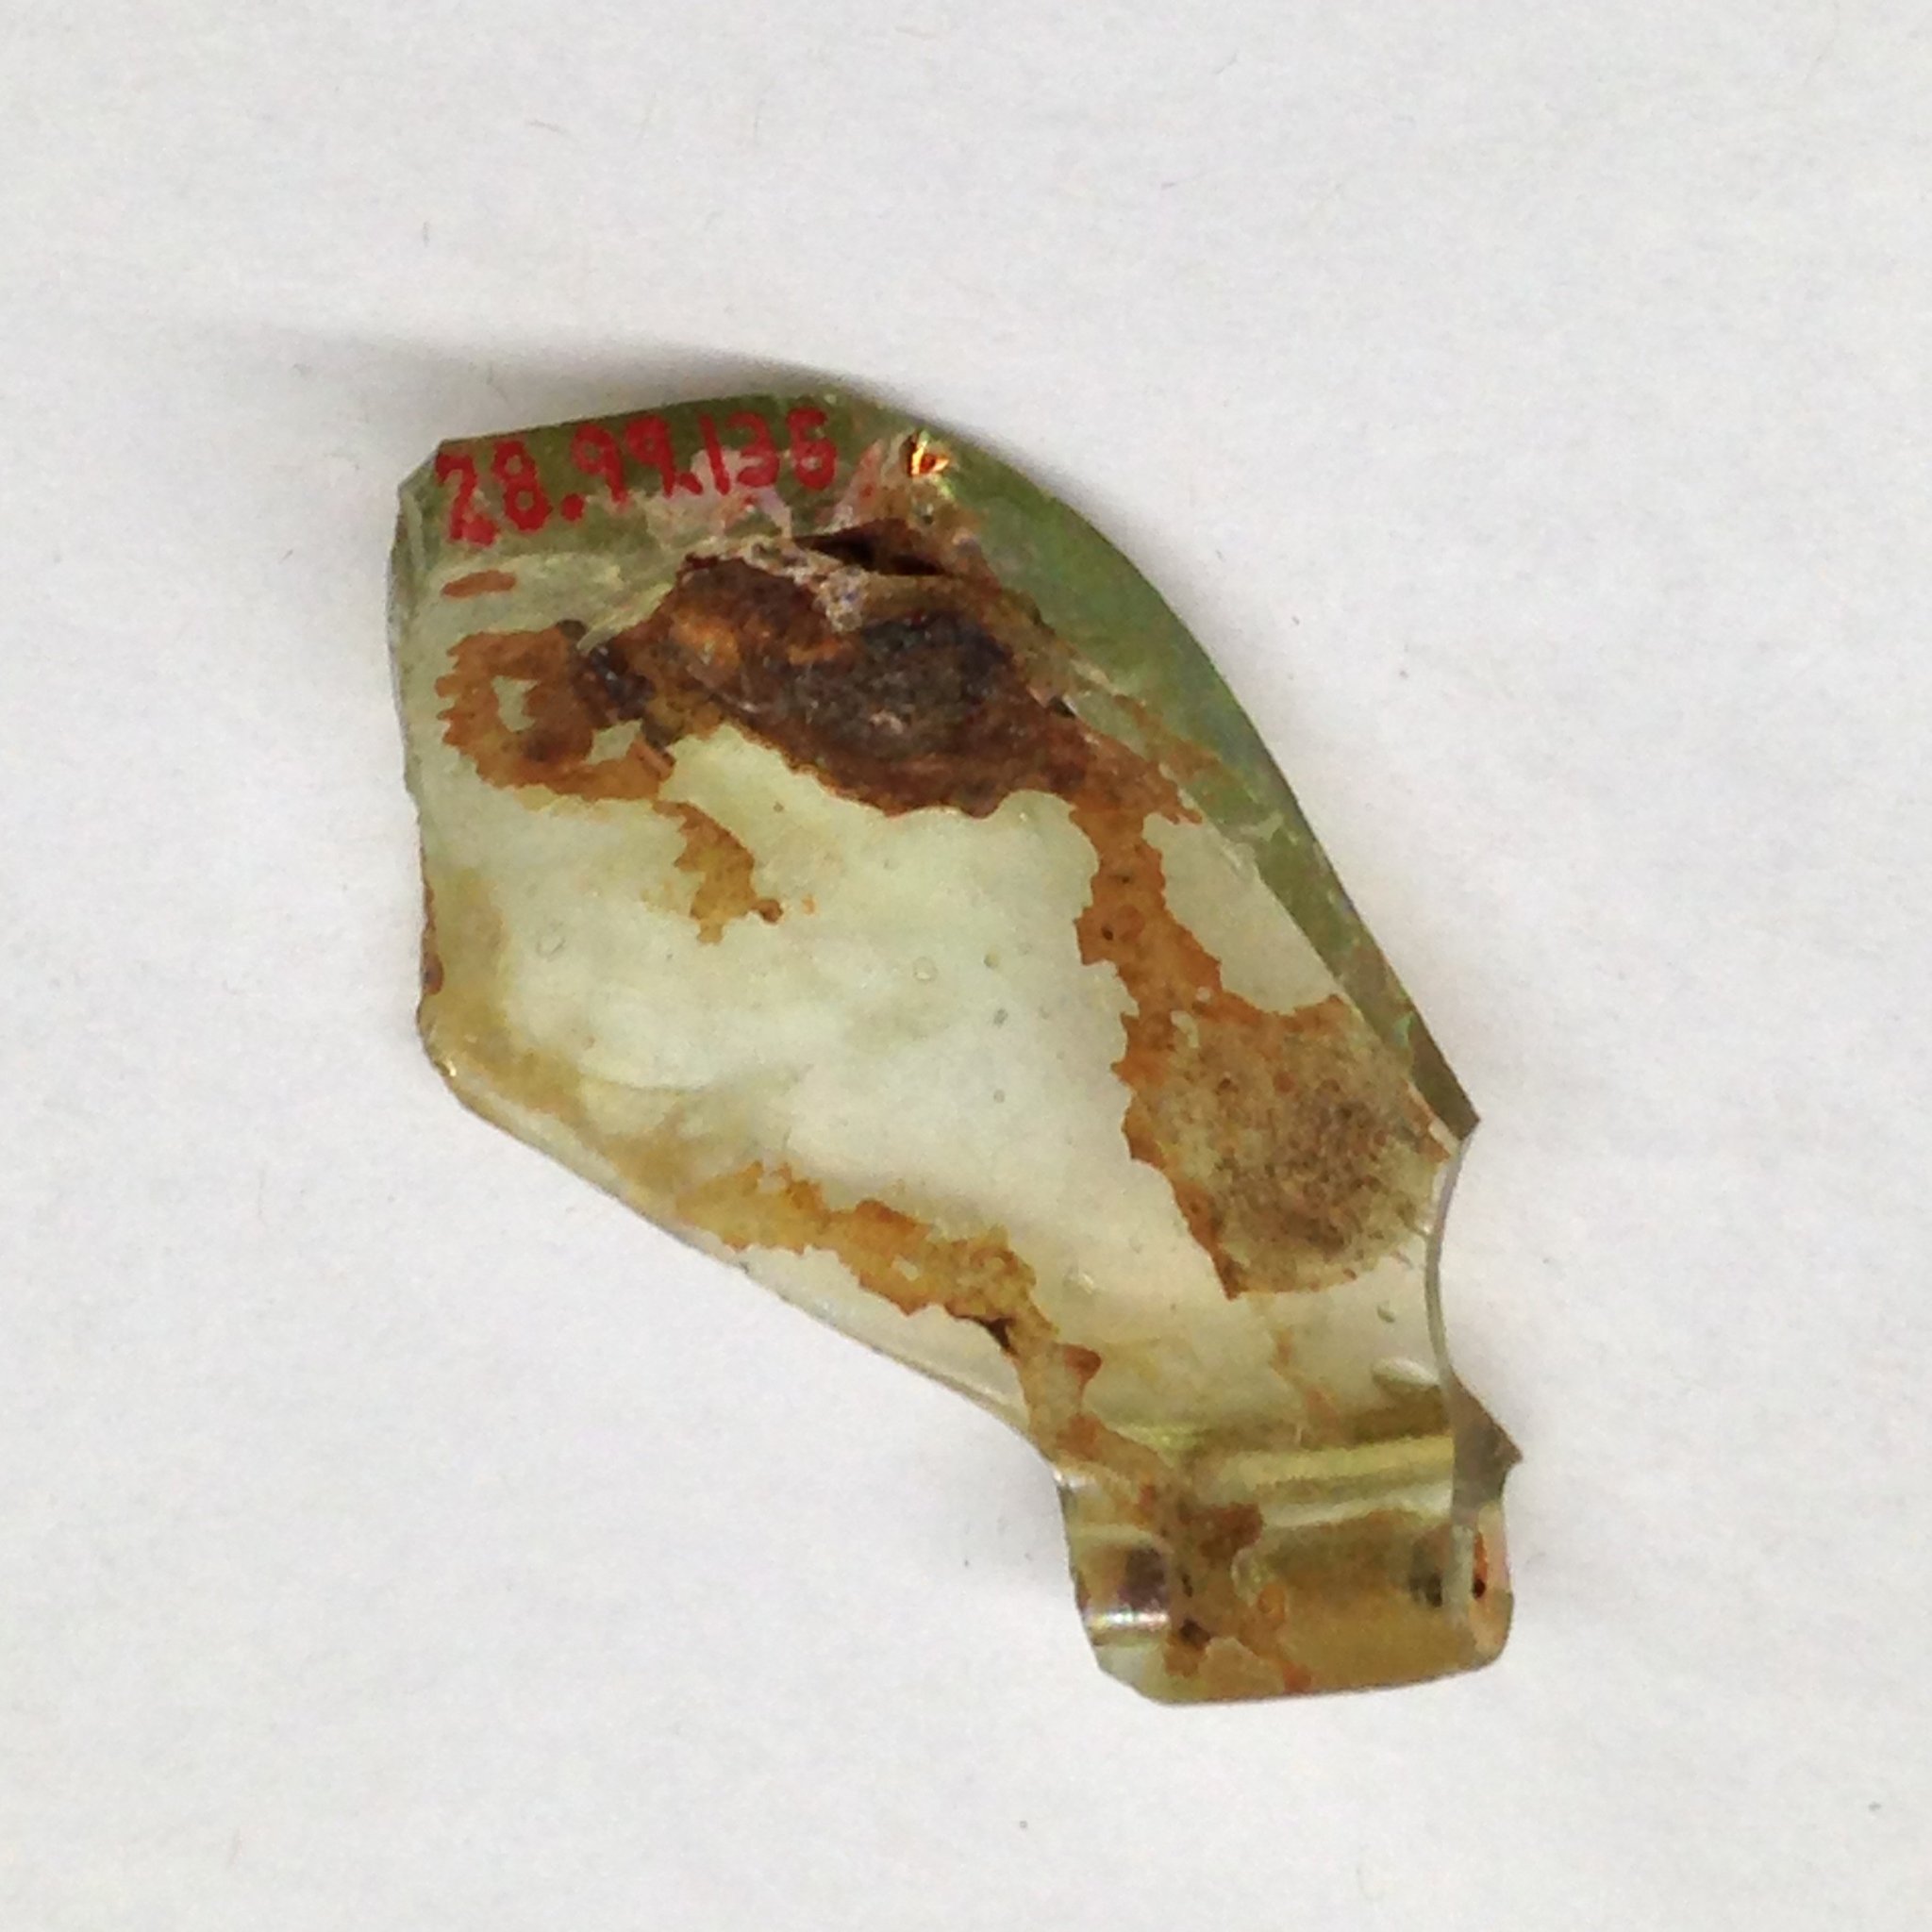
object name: fragment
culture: european or middle eastern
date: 1150-1250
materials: ceramic, glass